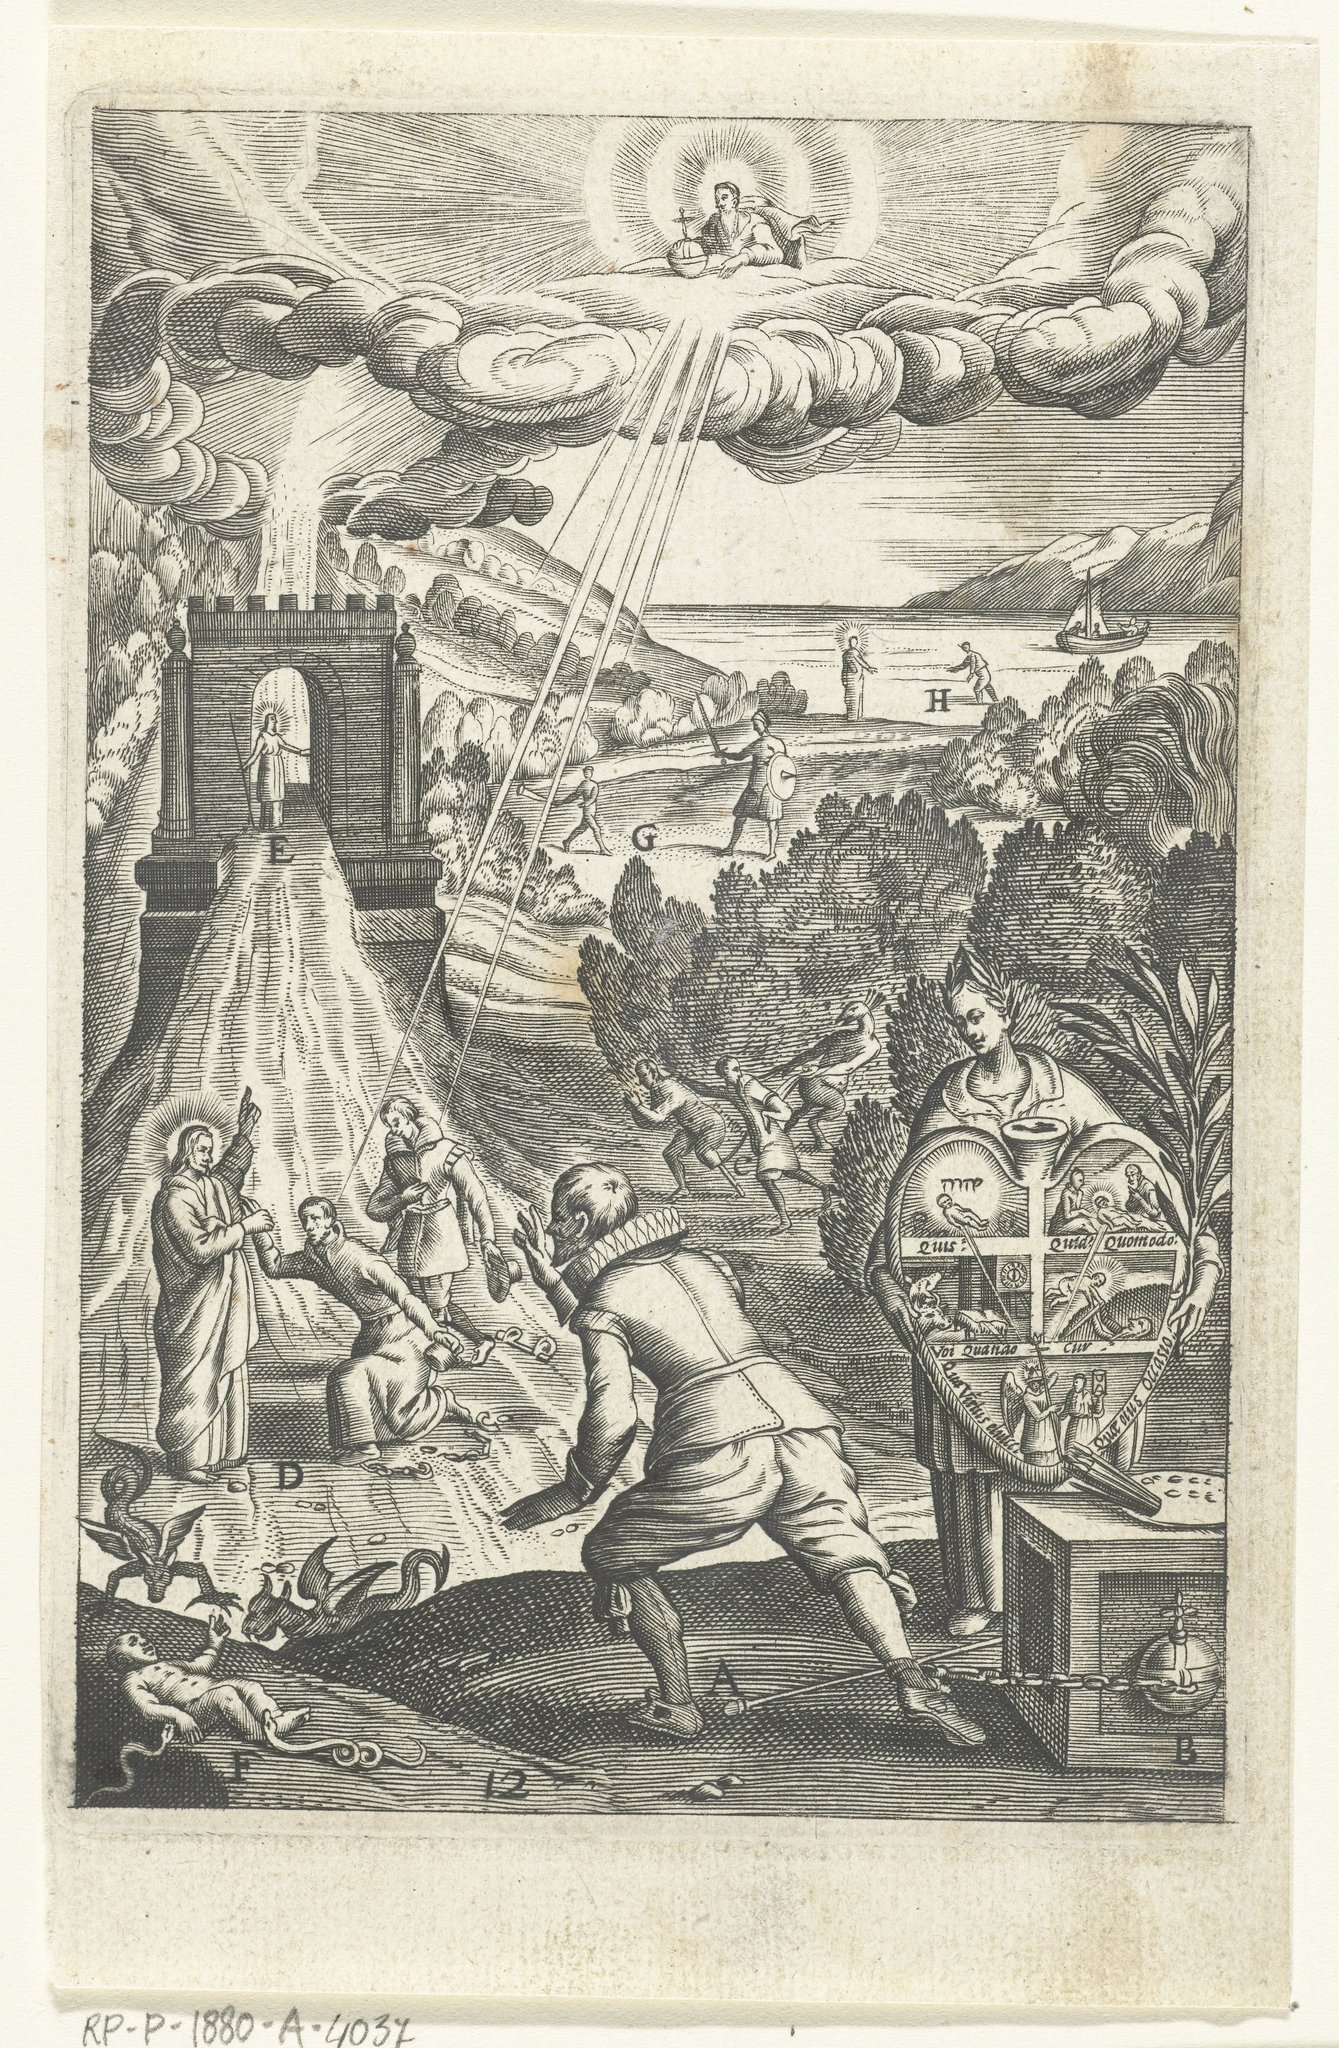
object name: print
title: Embleem met man die ziet hoe vertrouwen in God een mens kan verlossen van zonden en doen leven in deugd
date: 1620-1623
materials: paper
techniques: engraving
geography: antwerp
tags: the life of man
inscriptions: collector's mark: Lugt 2228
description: Een geketende man kijkt naar een tafereel waarbij Christus twee gelovige mannen verlost van hun zonden en hun ketenen. Hun vertrouwen in God doet hen leven in deugd en stuurt hen op de juiste weg naar het eeuwige leven die op de achtergrond is weergegeven. Als voorbeeld wordt een bijbelscène aangehaald: de herdersjongen David won de strijd tegen de grote Goliath door zijn standvastige geloof.